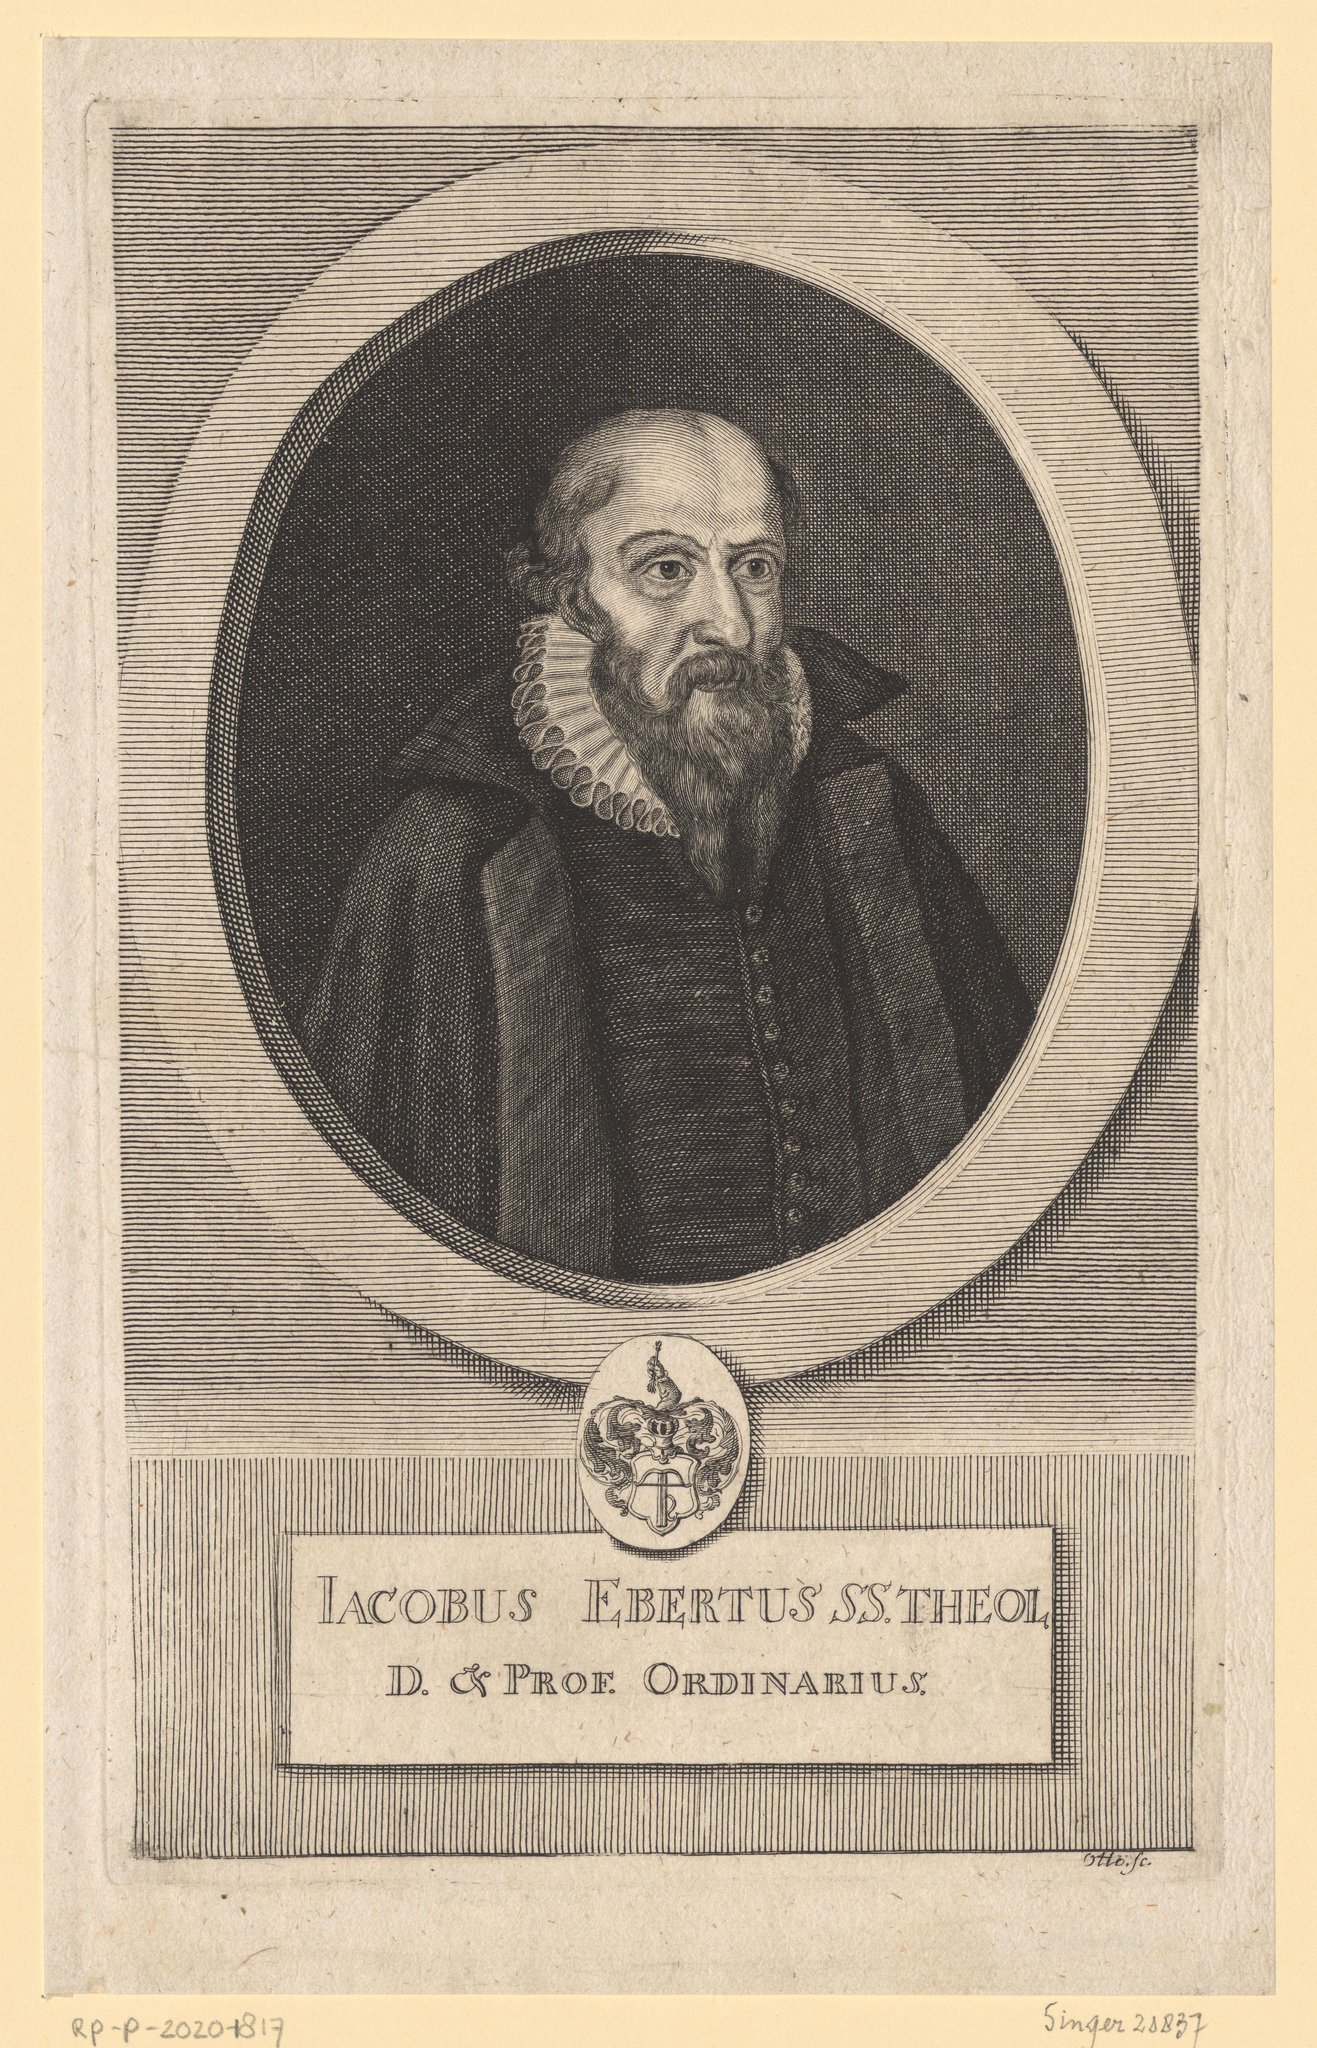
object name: book illustration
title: Portret van Jacob Ebert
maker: heinrich jakob otto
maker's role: print maker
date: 1707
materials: paper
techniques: engraving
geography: germany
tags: historical persons, armorial bearing, heraldry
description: Prent waarschijnlijk uit: Beckmann, Johann Christoph. Notitia universitatis Francofurtanae, una cum iconibus Personarum aliquot illustrium (...). Frankfurt: Jeremias Schrey en Johann Christoph Hartmann, 1707.